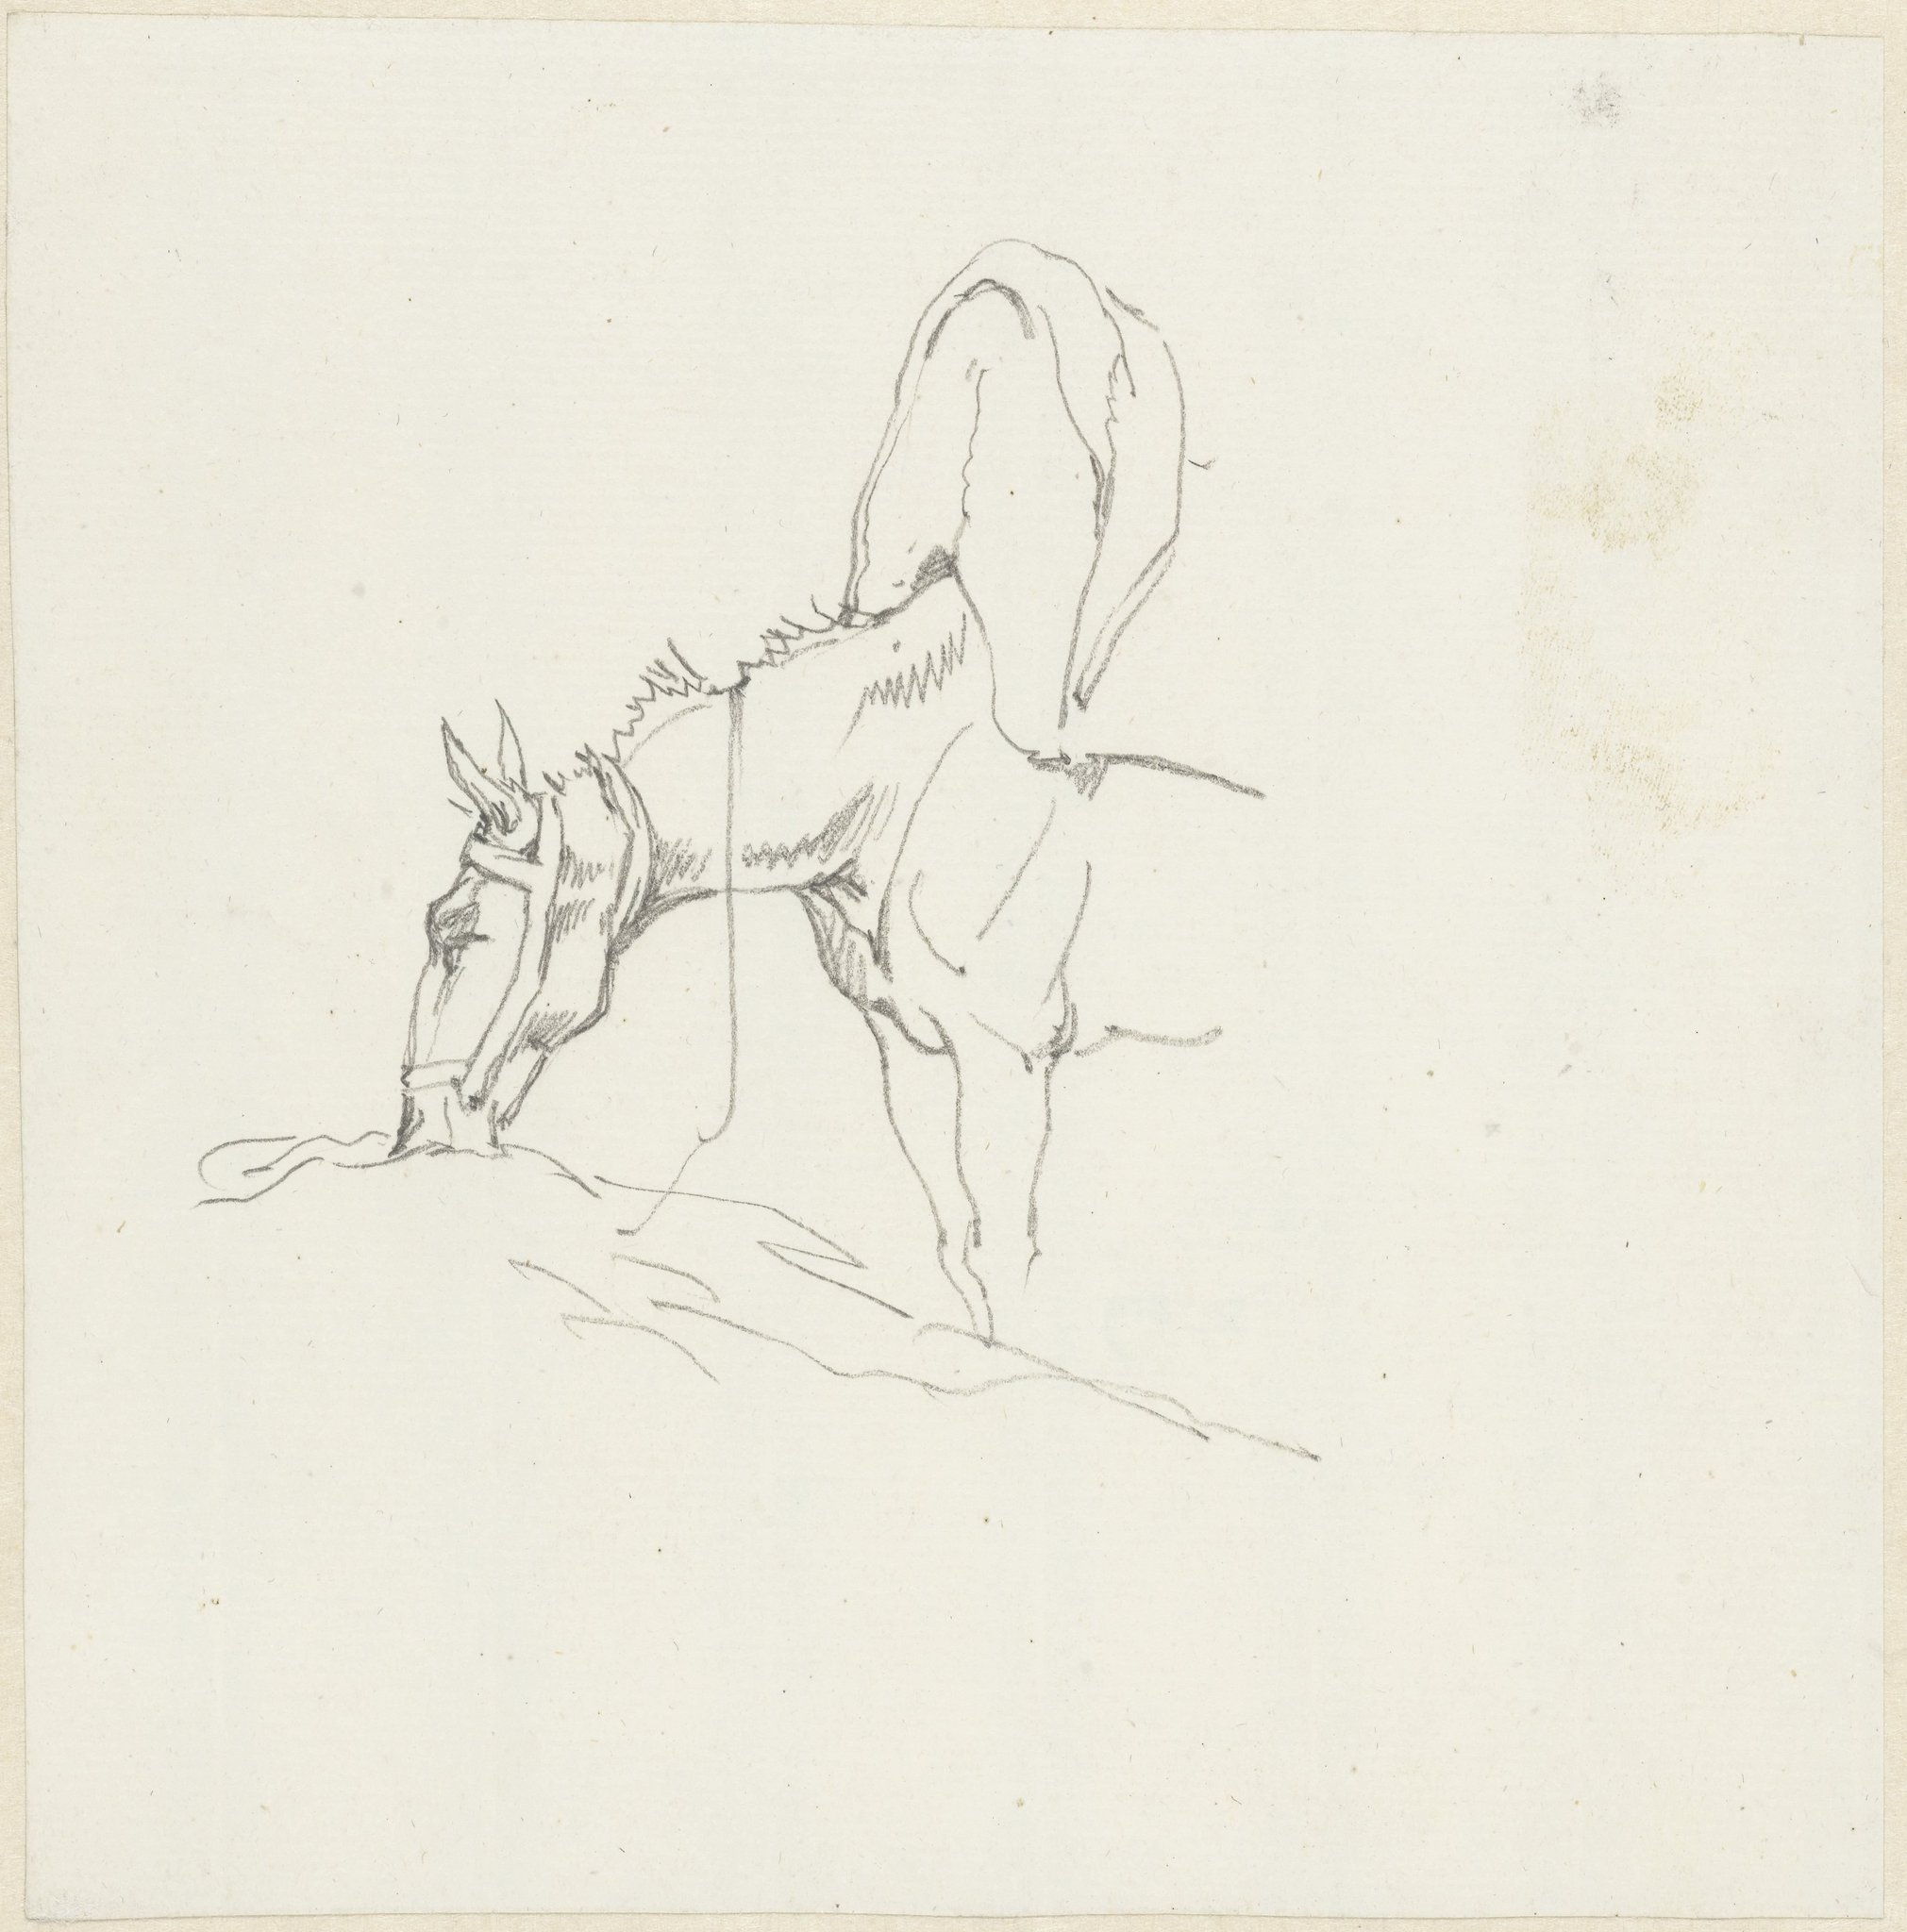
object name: drawing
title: Een etend lastpaard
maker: hendrik voogd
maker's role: draughtsman, painter, print maker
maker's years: 1768-1839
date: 1788-1839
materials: paper, pencil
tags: pack-animal, horse